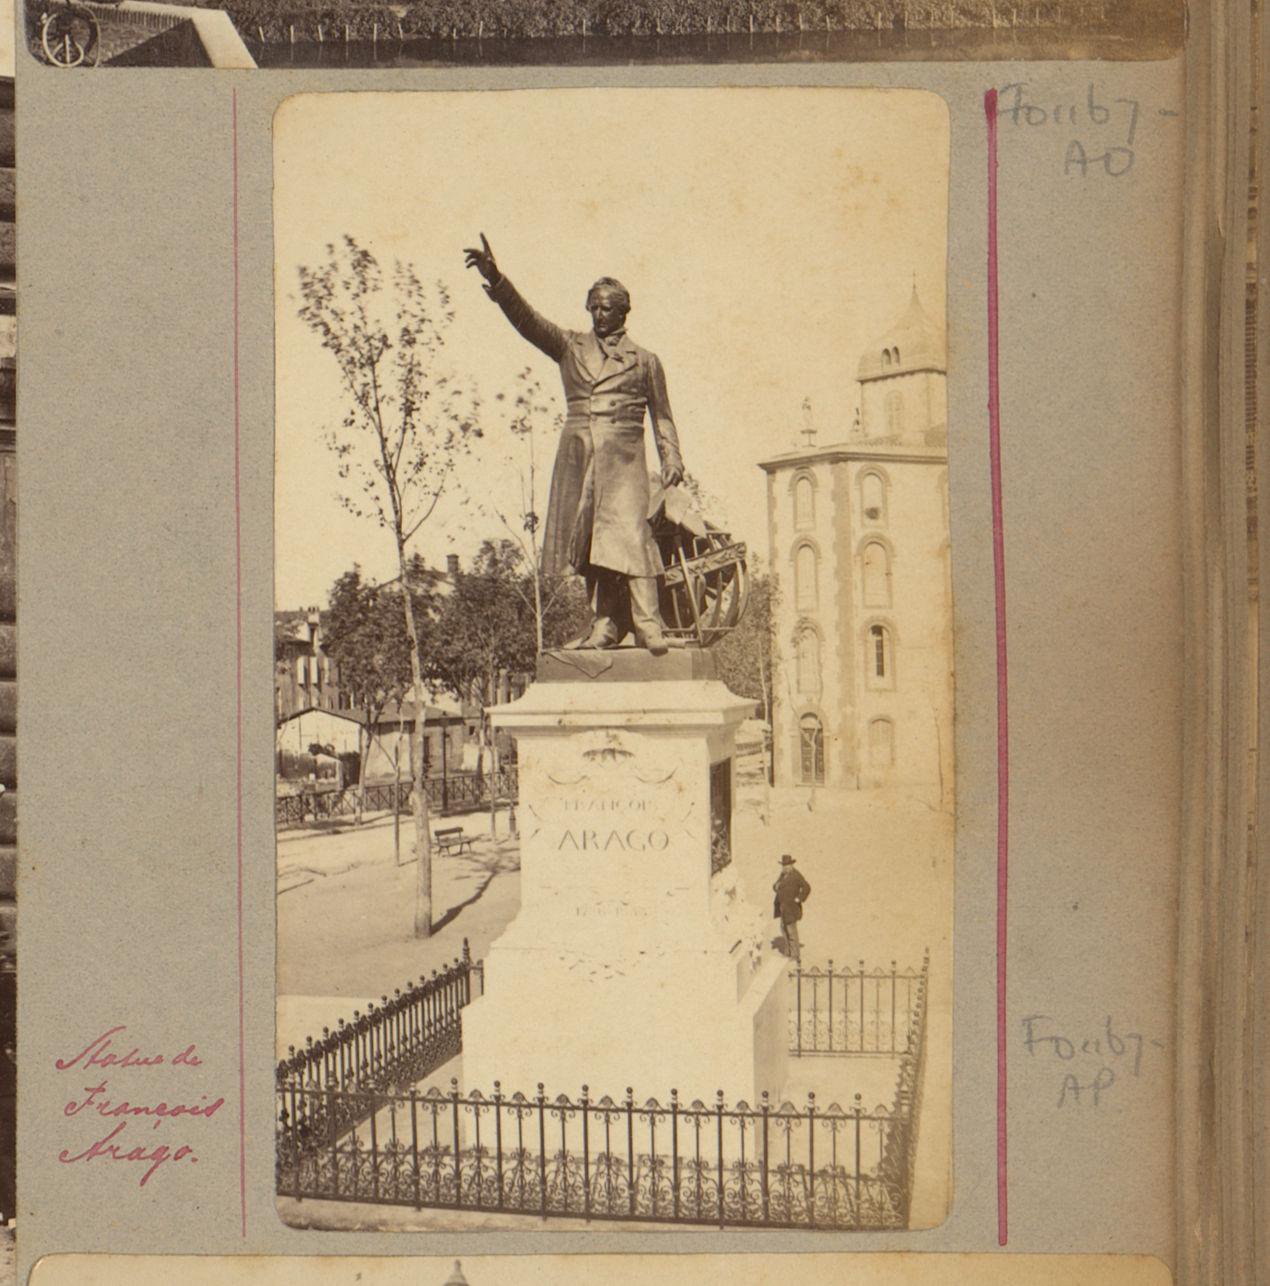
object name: album leaf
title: Standbeeld van François Arago te Perpignan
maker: Anonymous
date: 1880-1910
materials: photographic support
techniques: albumen print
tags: monument, statue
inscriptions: annotation: ‘Statue de François Arago’